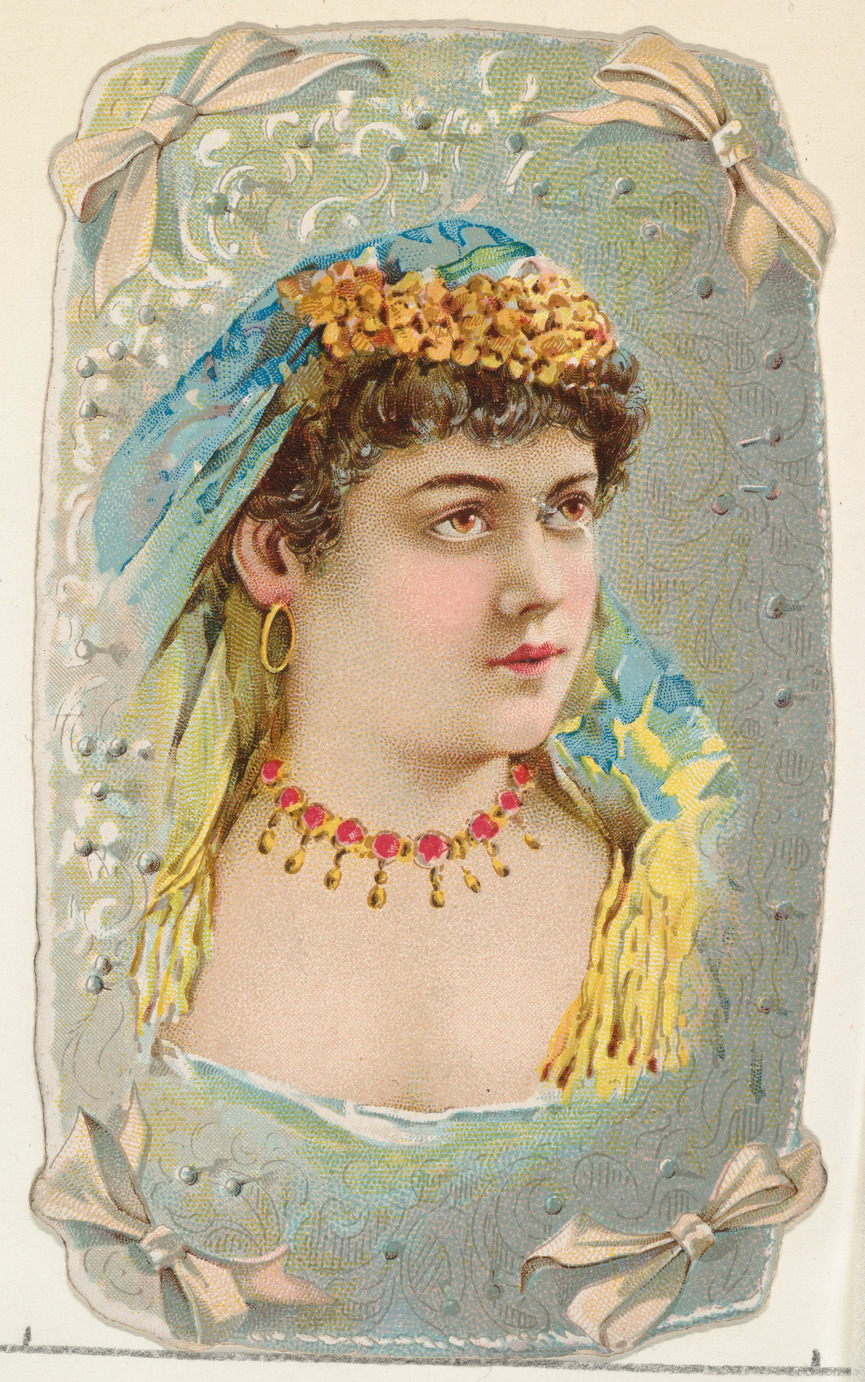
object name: print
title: Pin Cushion, from the Novelties series (N122) issued by Gail & Ax Tobacco to promote Navy Long Cut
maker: gail & ax tobacco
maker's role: publisher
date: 1889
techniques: color lithograph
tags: women